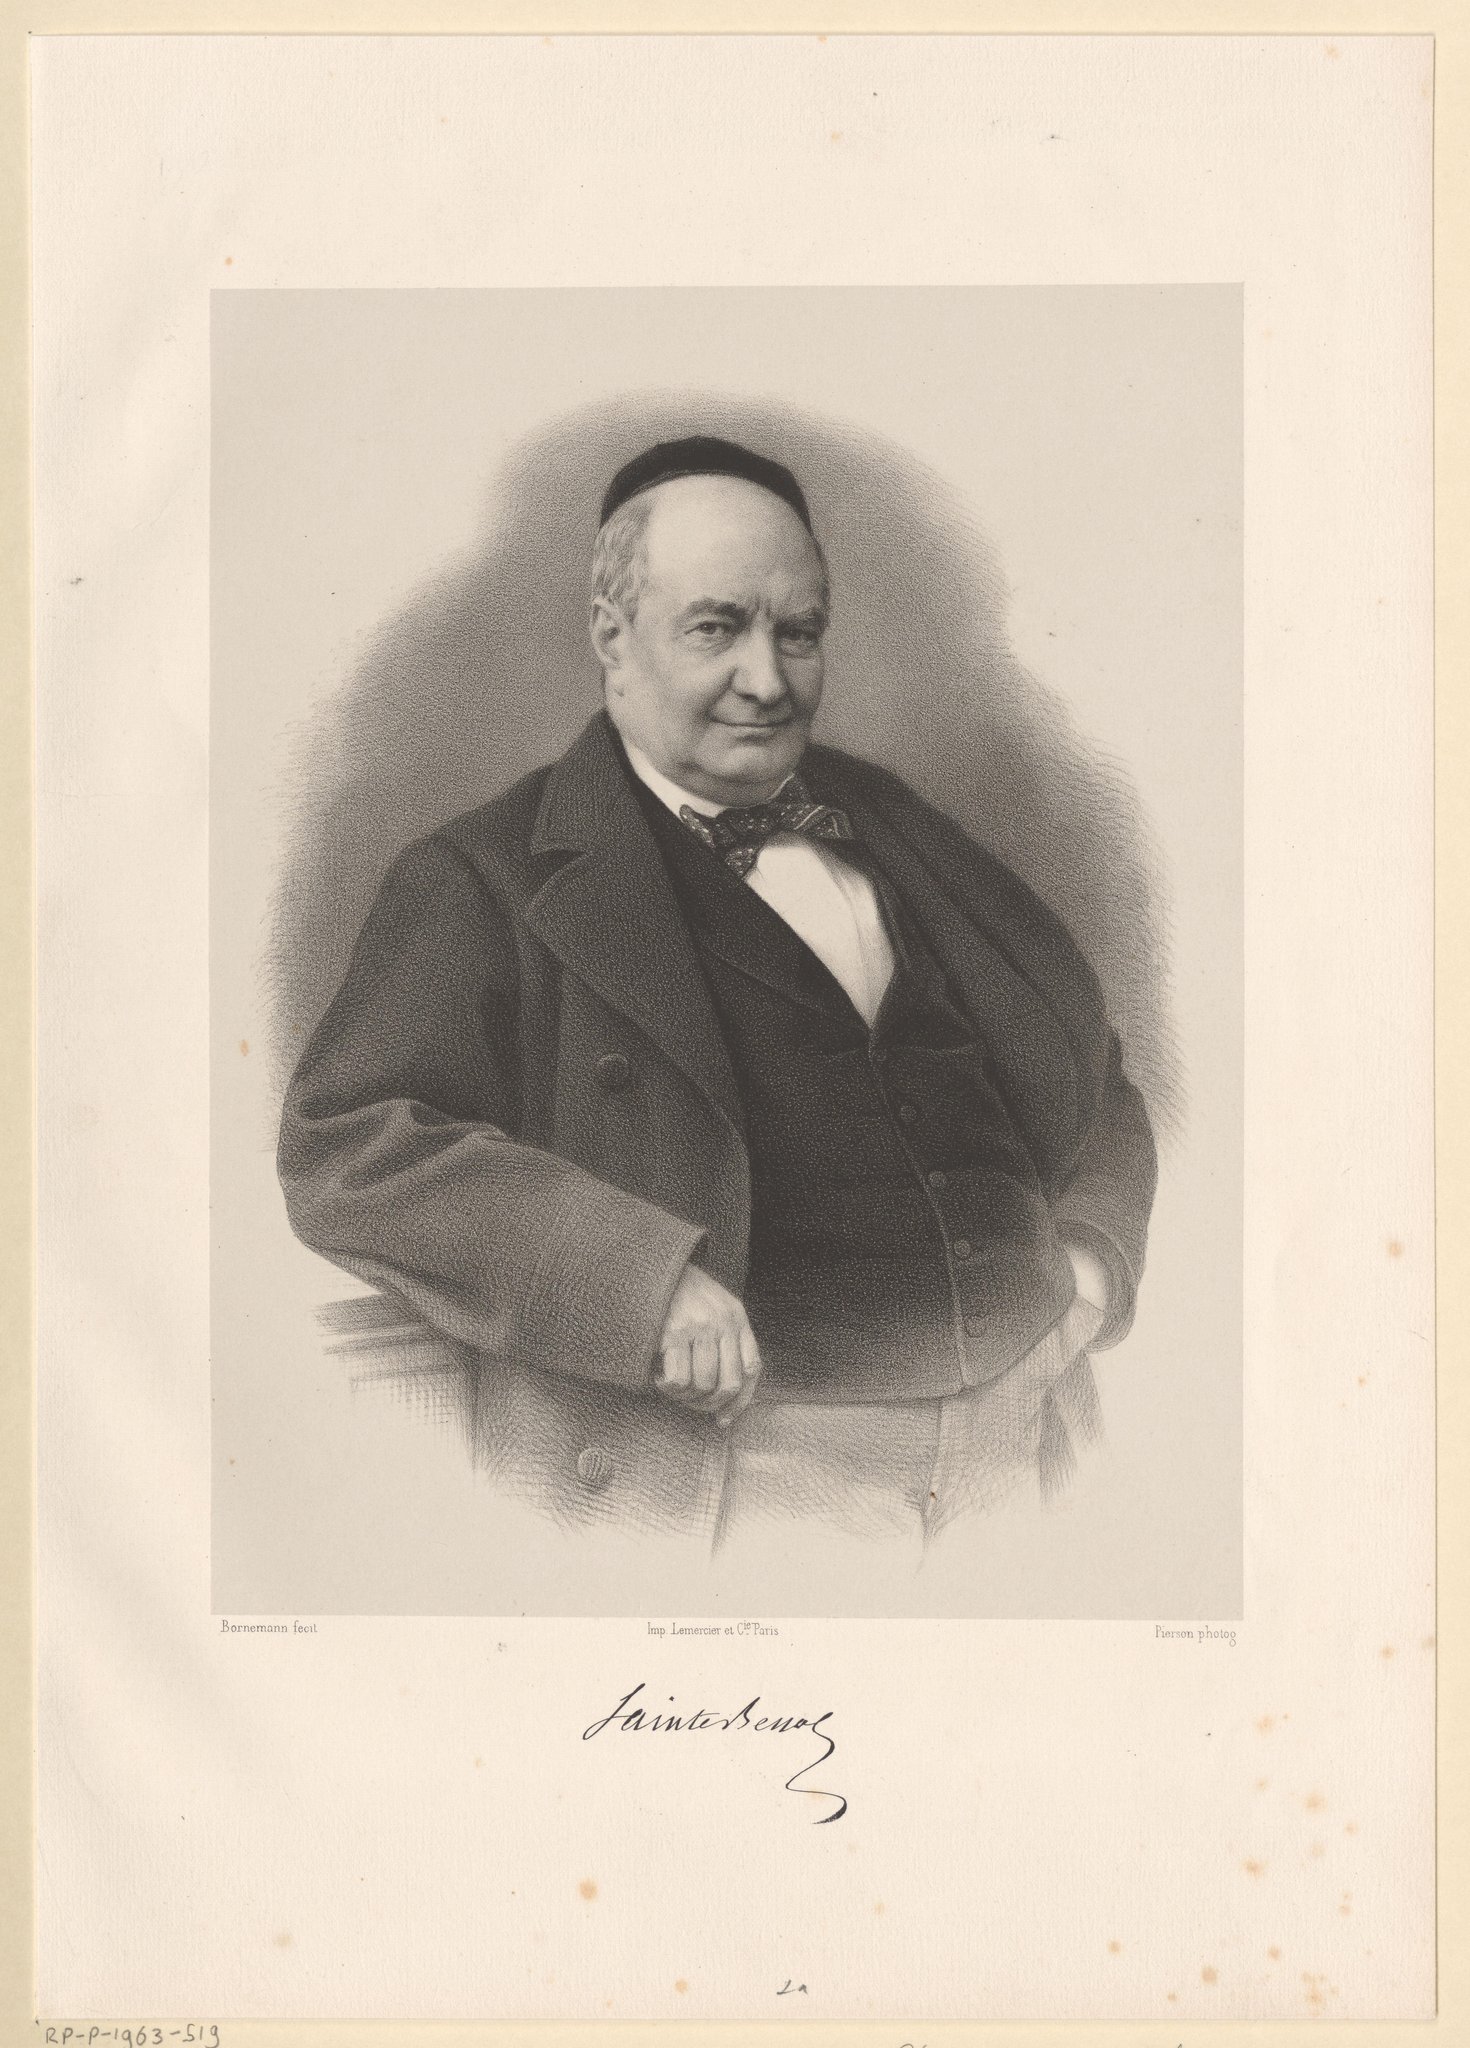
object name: print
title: Portret van Charles Augustin Sainte-Beuve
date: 1828-1901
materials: paper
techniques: lithograph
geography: paris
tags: paris, politician, historical persons, portrait of a writer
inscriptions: collector's mark: Lugt 2228